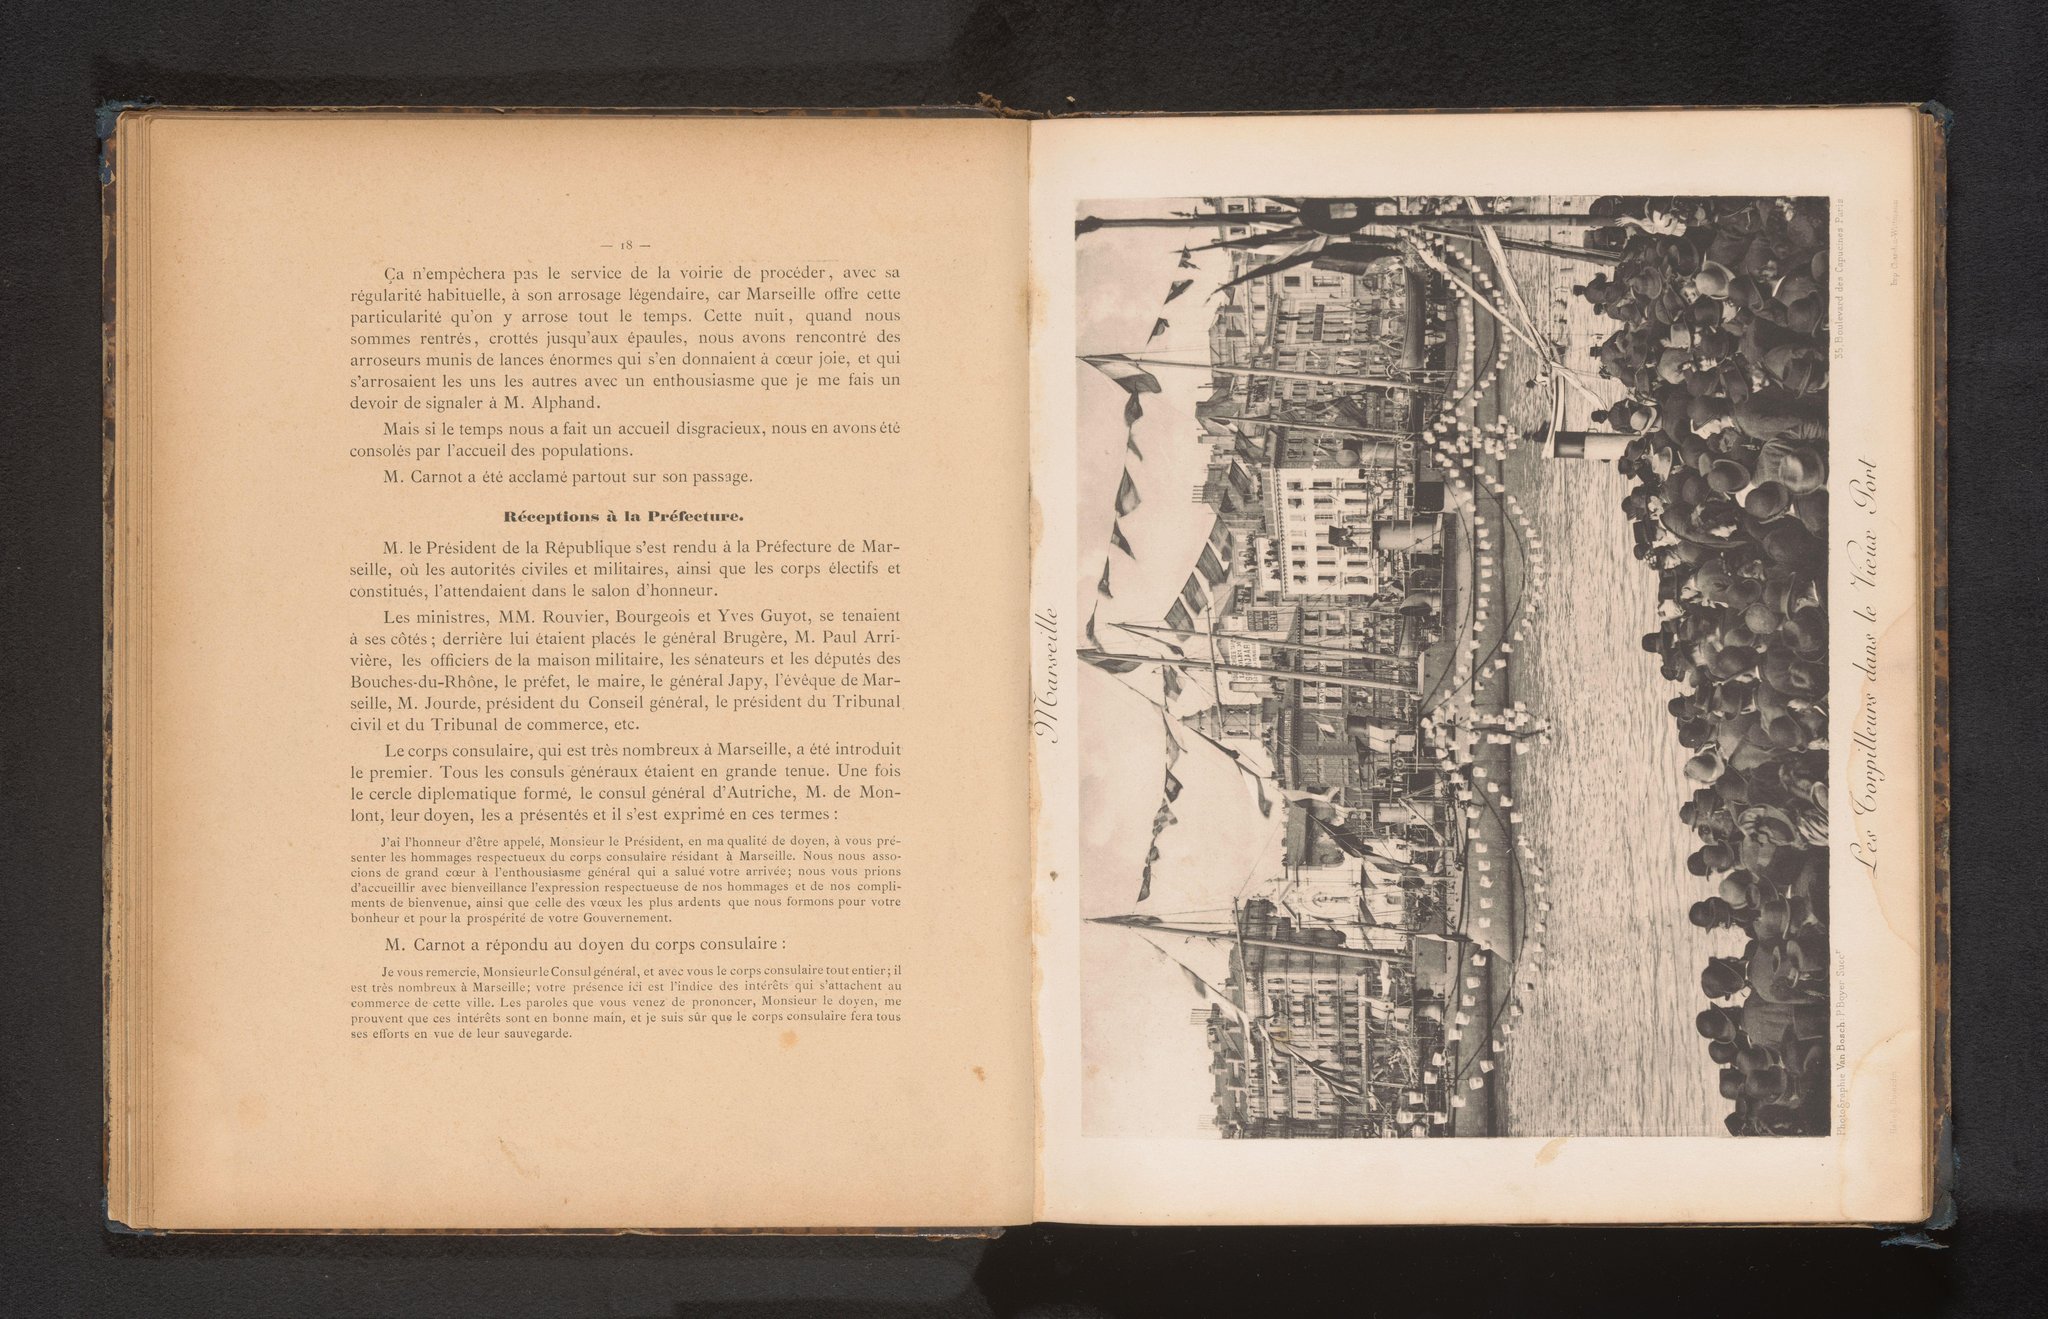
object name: photomechanical print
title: Les torpilleurs dans le vieux port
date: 1885-1890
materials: paper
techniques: photoaquatint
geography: marseille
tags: harbour, ships (in general)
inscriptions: inscription: ‘35 Boulevard des Capucines Paris’